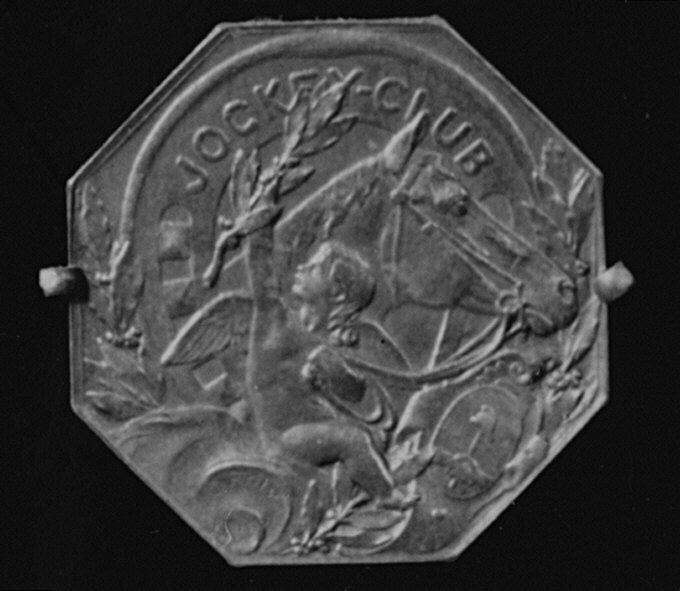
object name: jeton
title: For the Jockey Club of Buenos Aires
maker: louis-oscar roty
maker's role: artist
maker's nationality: french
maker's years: 1846-1911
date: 1889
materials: silver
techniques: struck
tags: horses